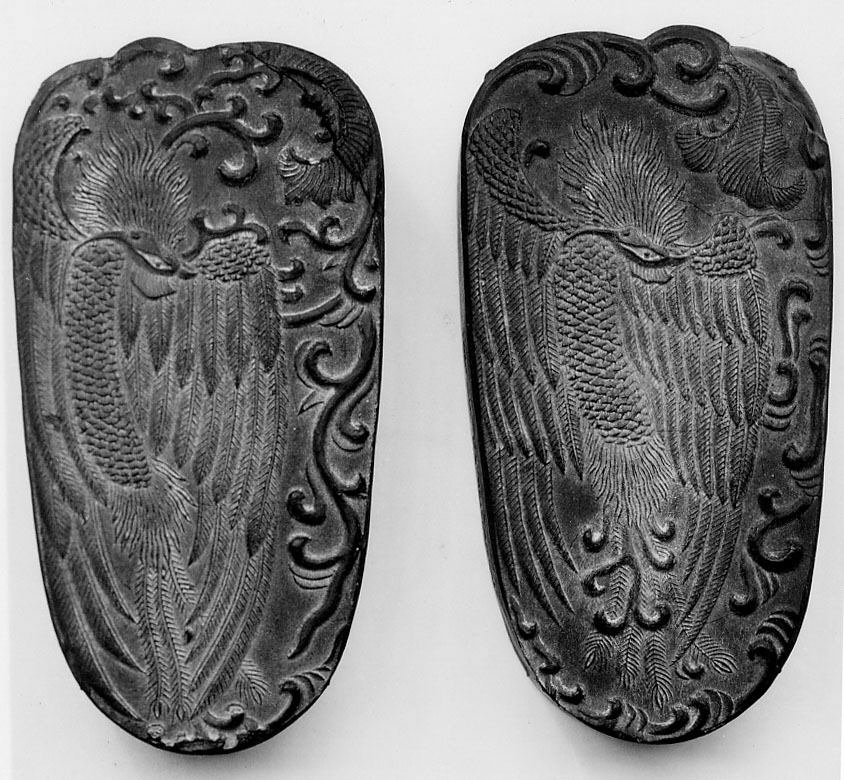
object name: ink tablet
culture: chinese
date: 1736-1795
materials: ink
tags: phoenix